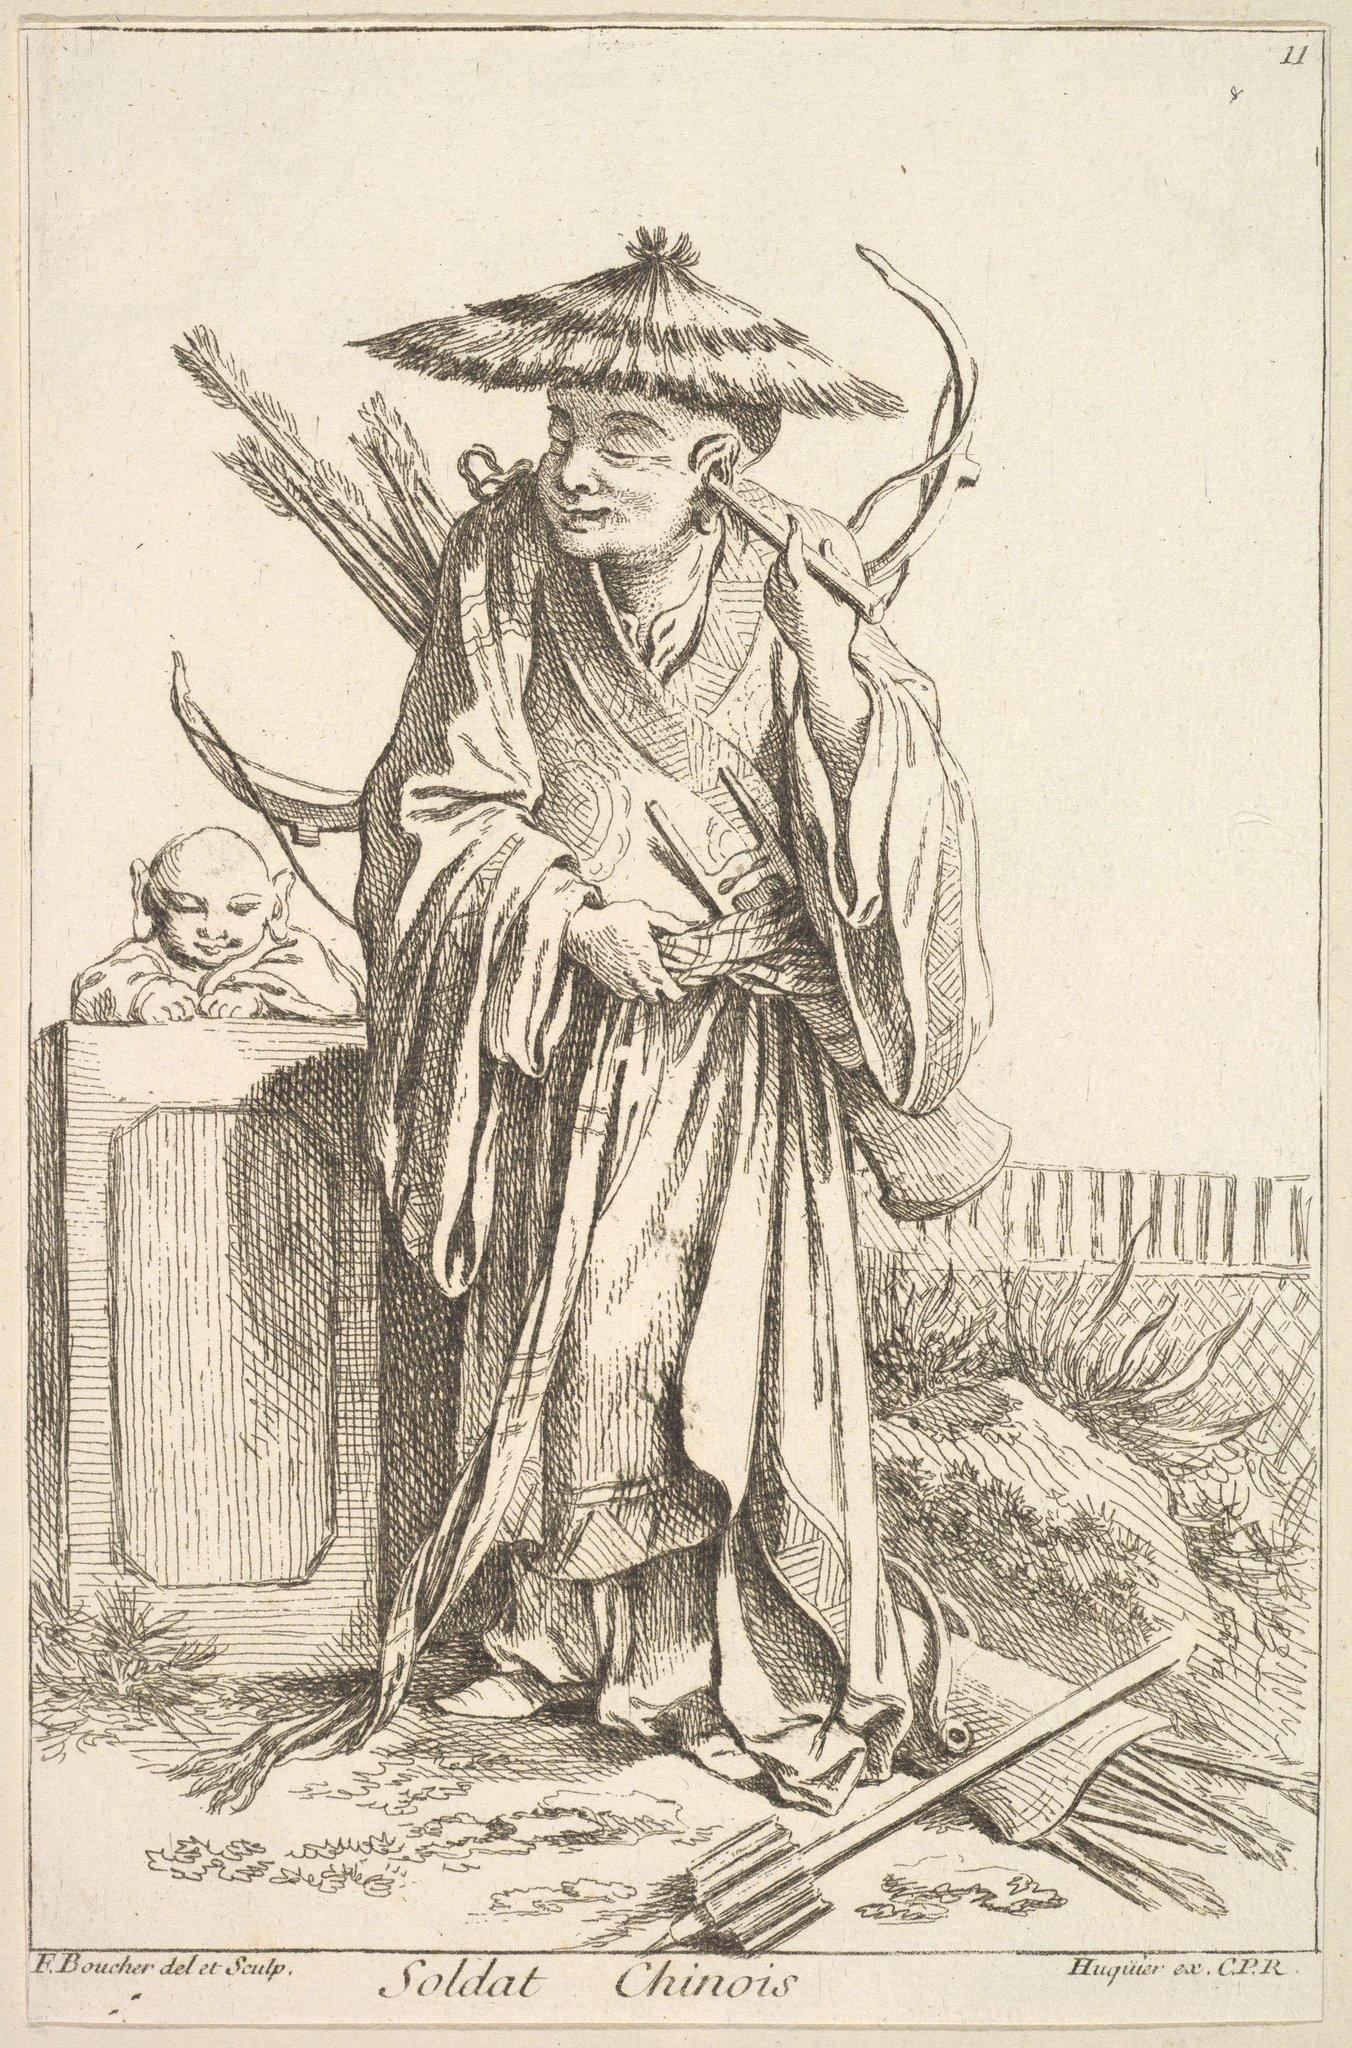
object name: print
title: Chinese Soldier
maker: françois boucher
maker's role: artist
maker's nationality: french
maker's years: 1703-1770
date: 1738-1745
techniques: etching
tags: soldiers